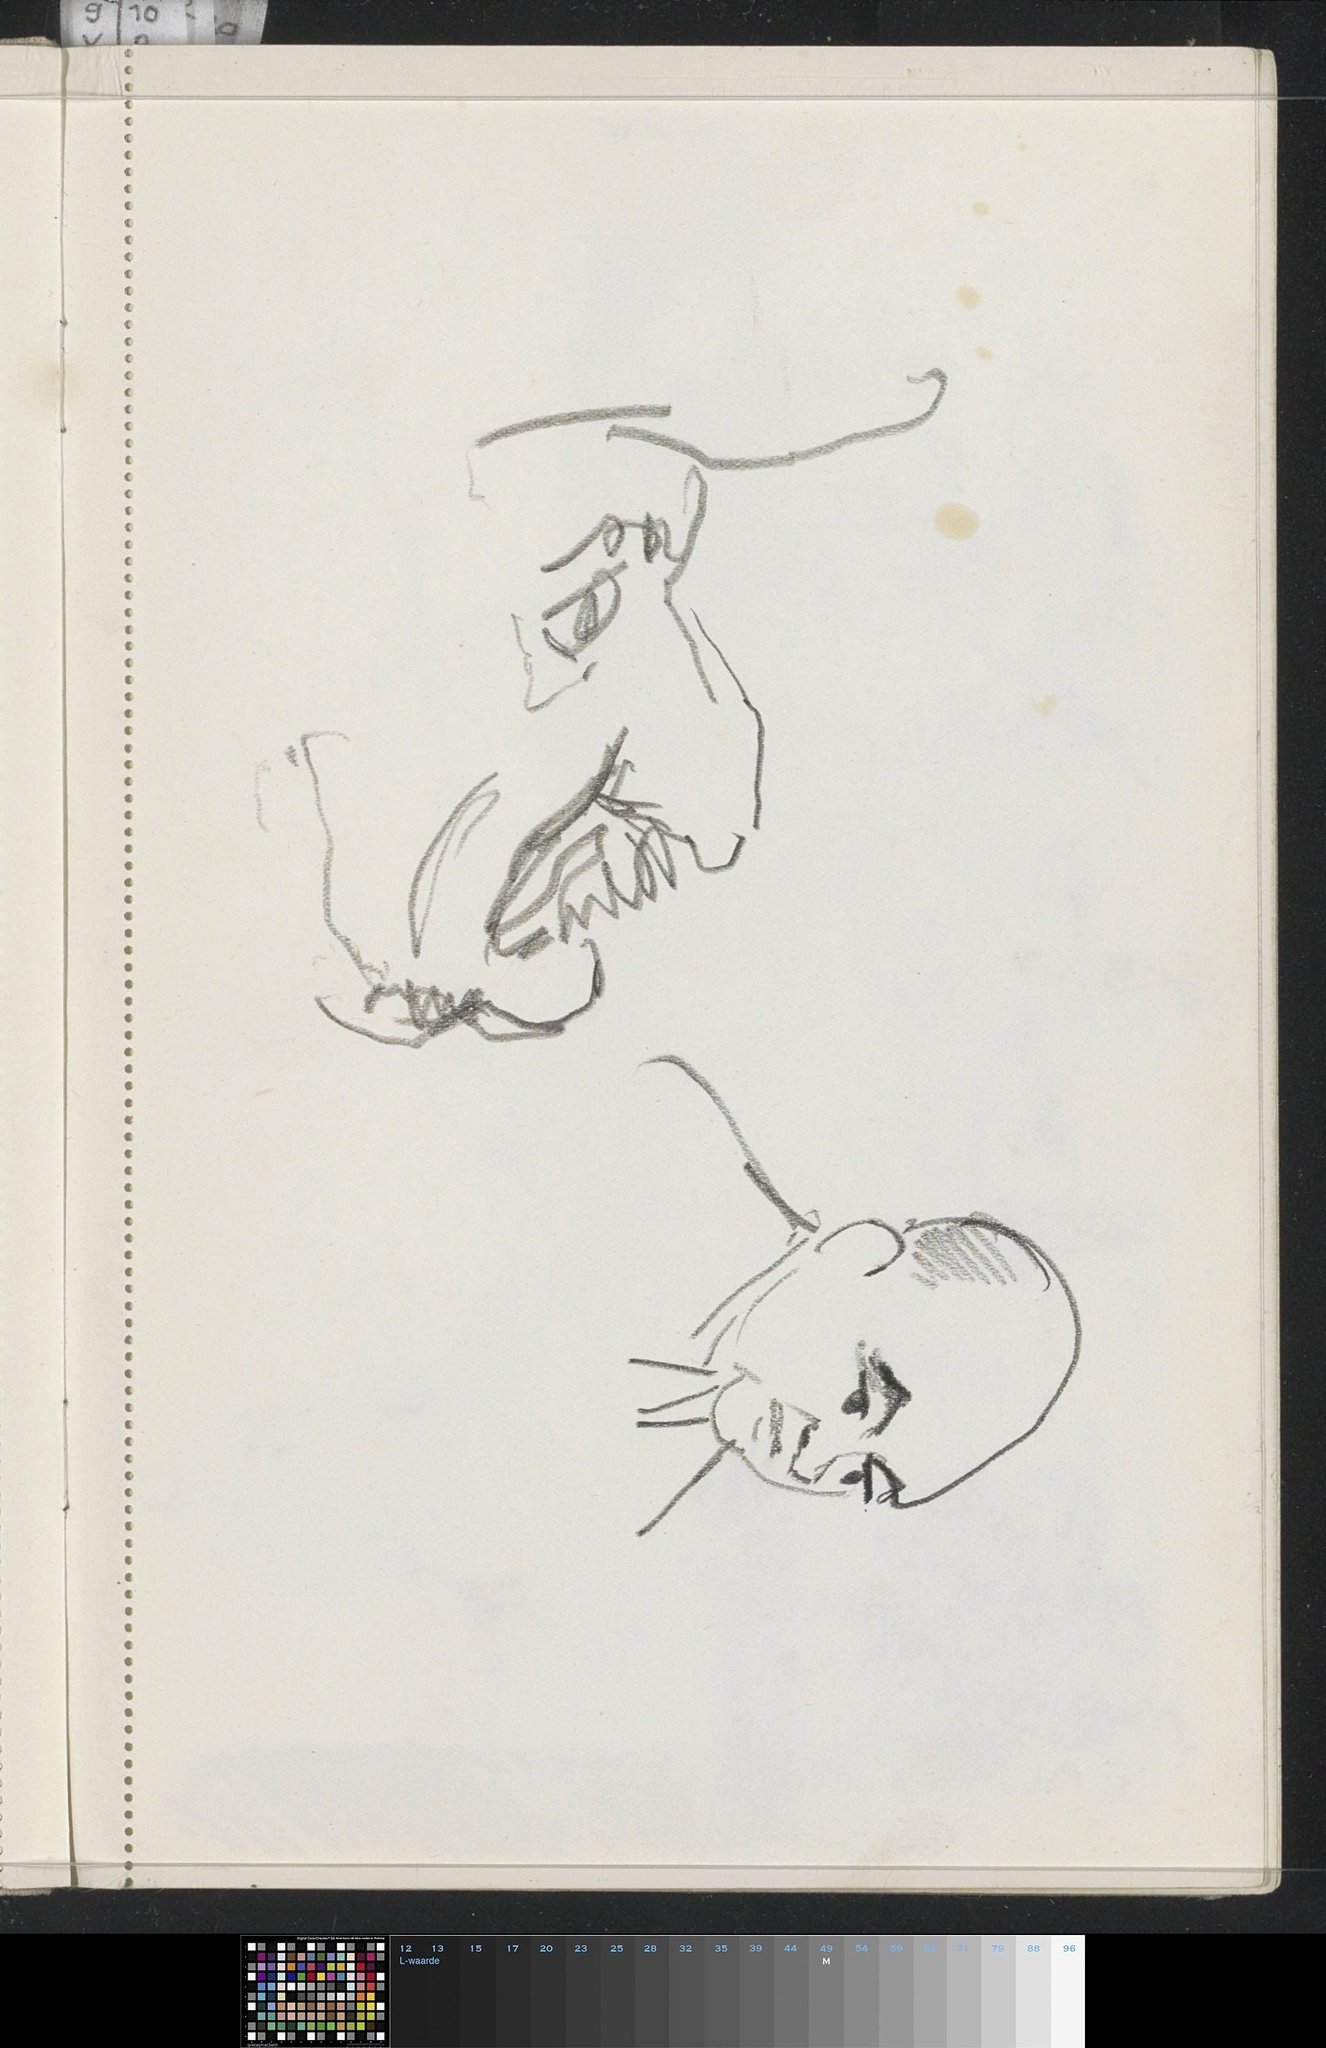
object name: sketchbook leaf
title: Twee mannenkoppen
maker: cornelis vreedenburgh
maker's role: draughtsman, print maker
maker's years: 1880-1946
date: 1935-1936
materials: paper, pencil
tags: head (human)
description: Blad 6 recto uit een schetsboek met 73 bladen.